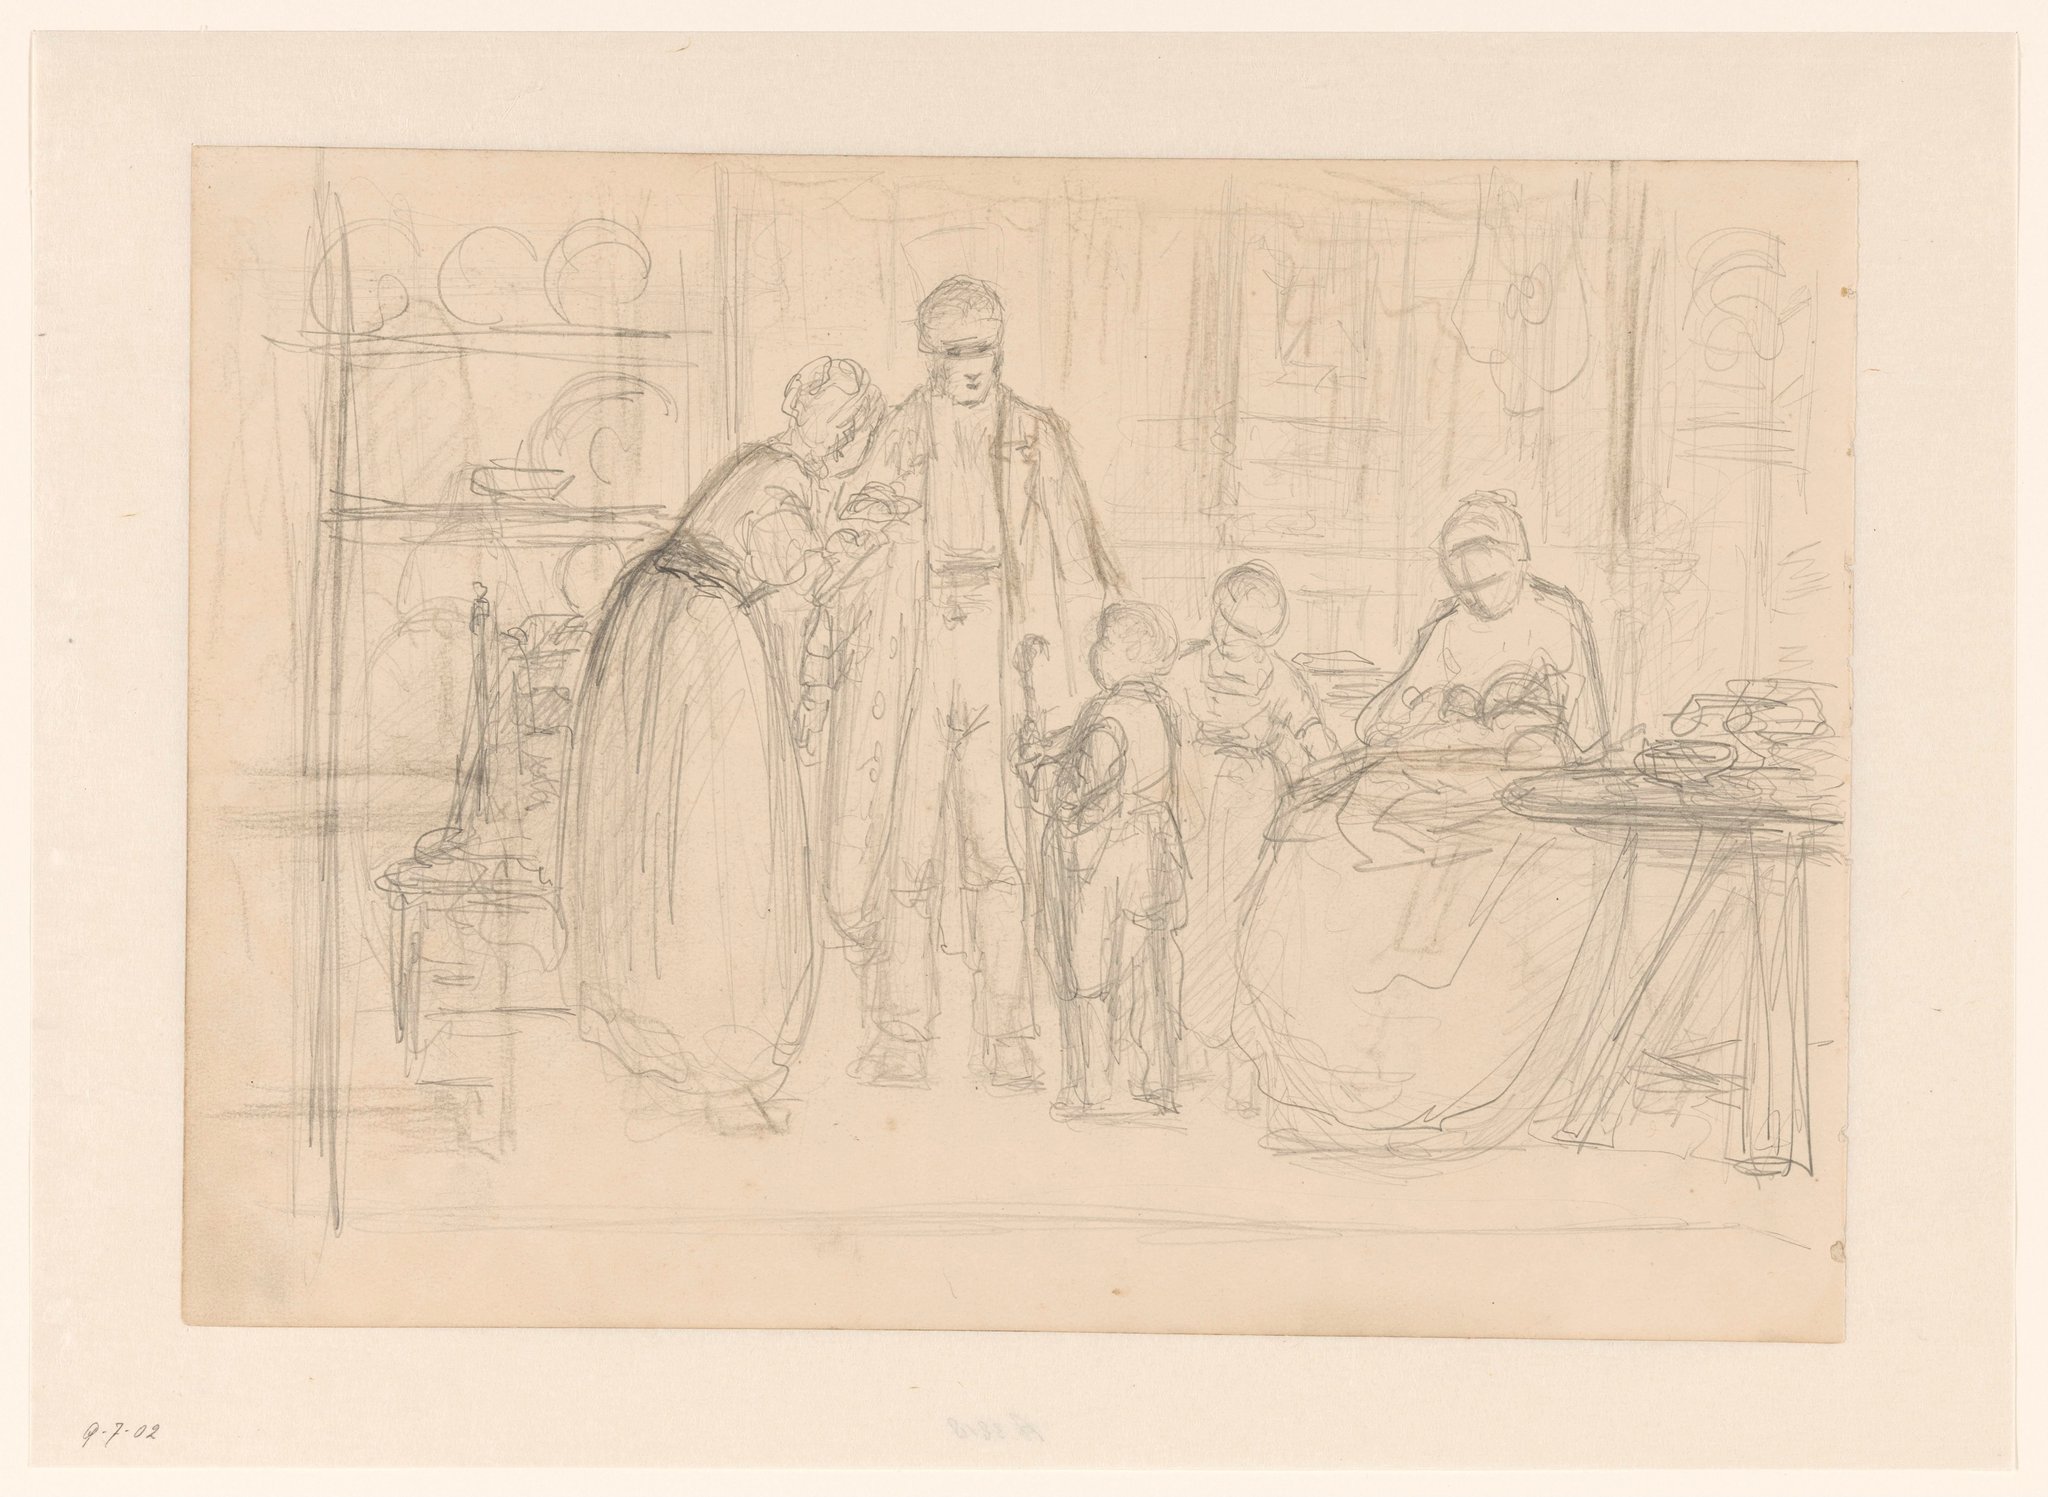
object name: drawing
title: Familie in interieur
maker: hendrik valkenburg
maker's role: draughtsman, painter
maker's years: 1826-1896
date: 1836-1896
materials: paper, pencil